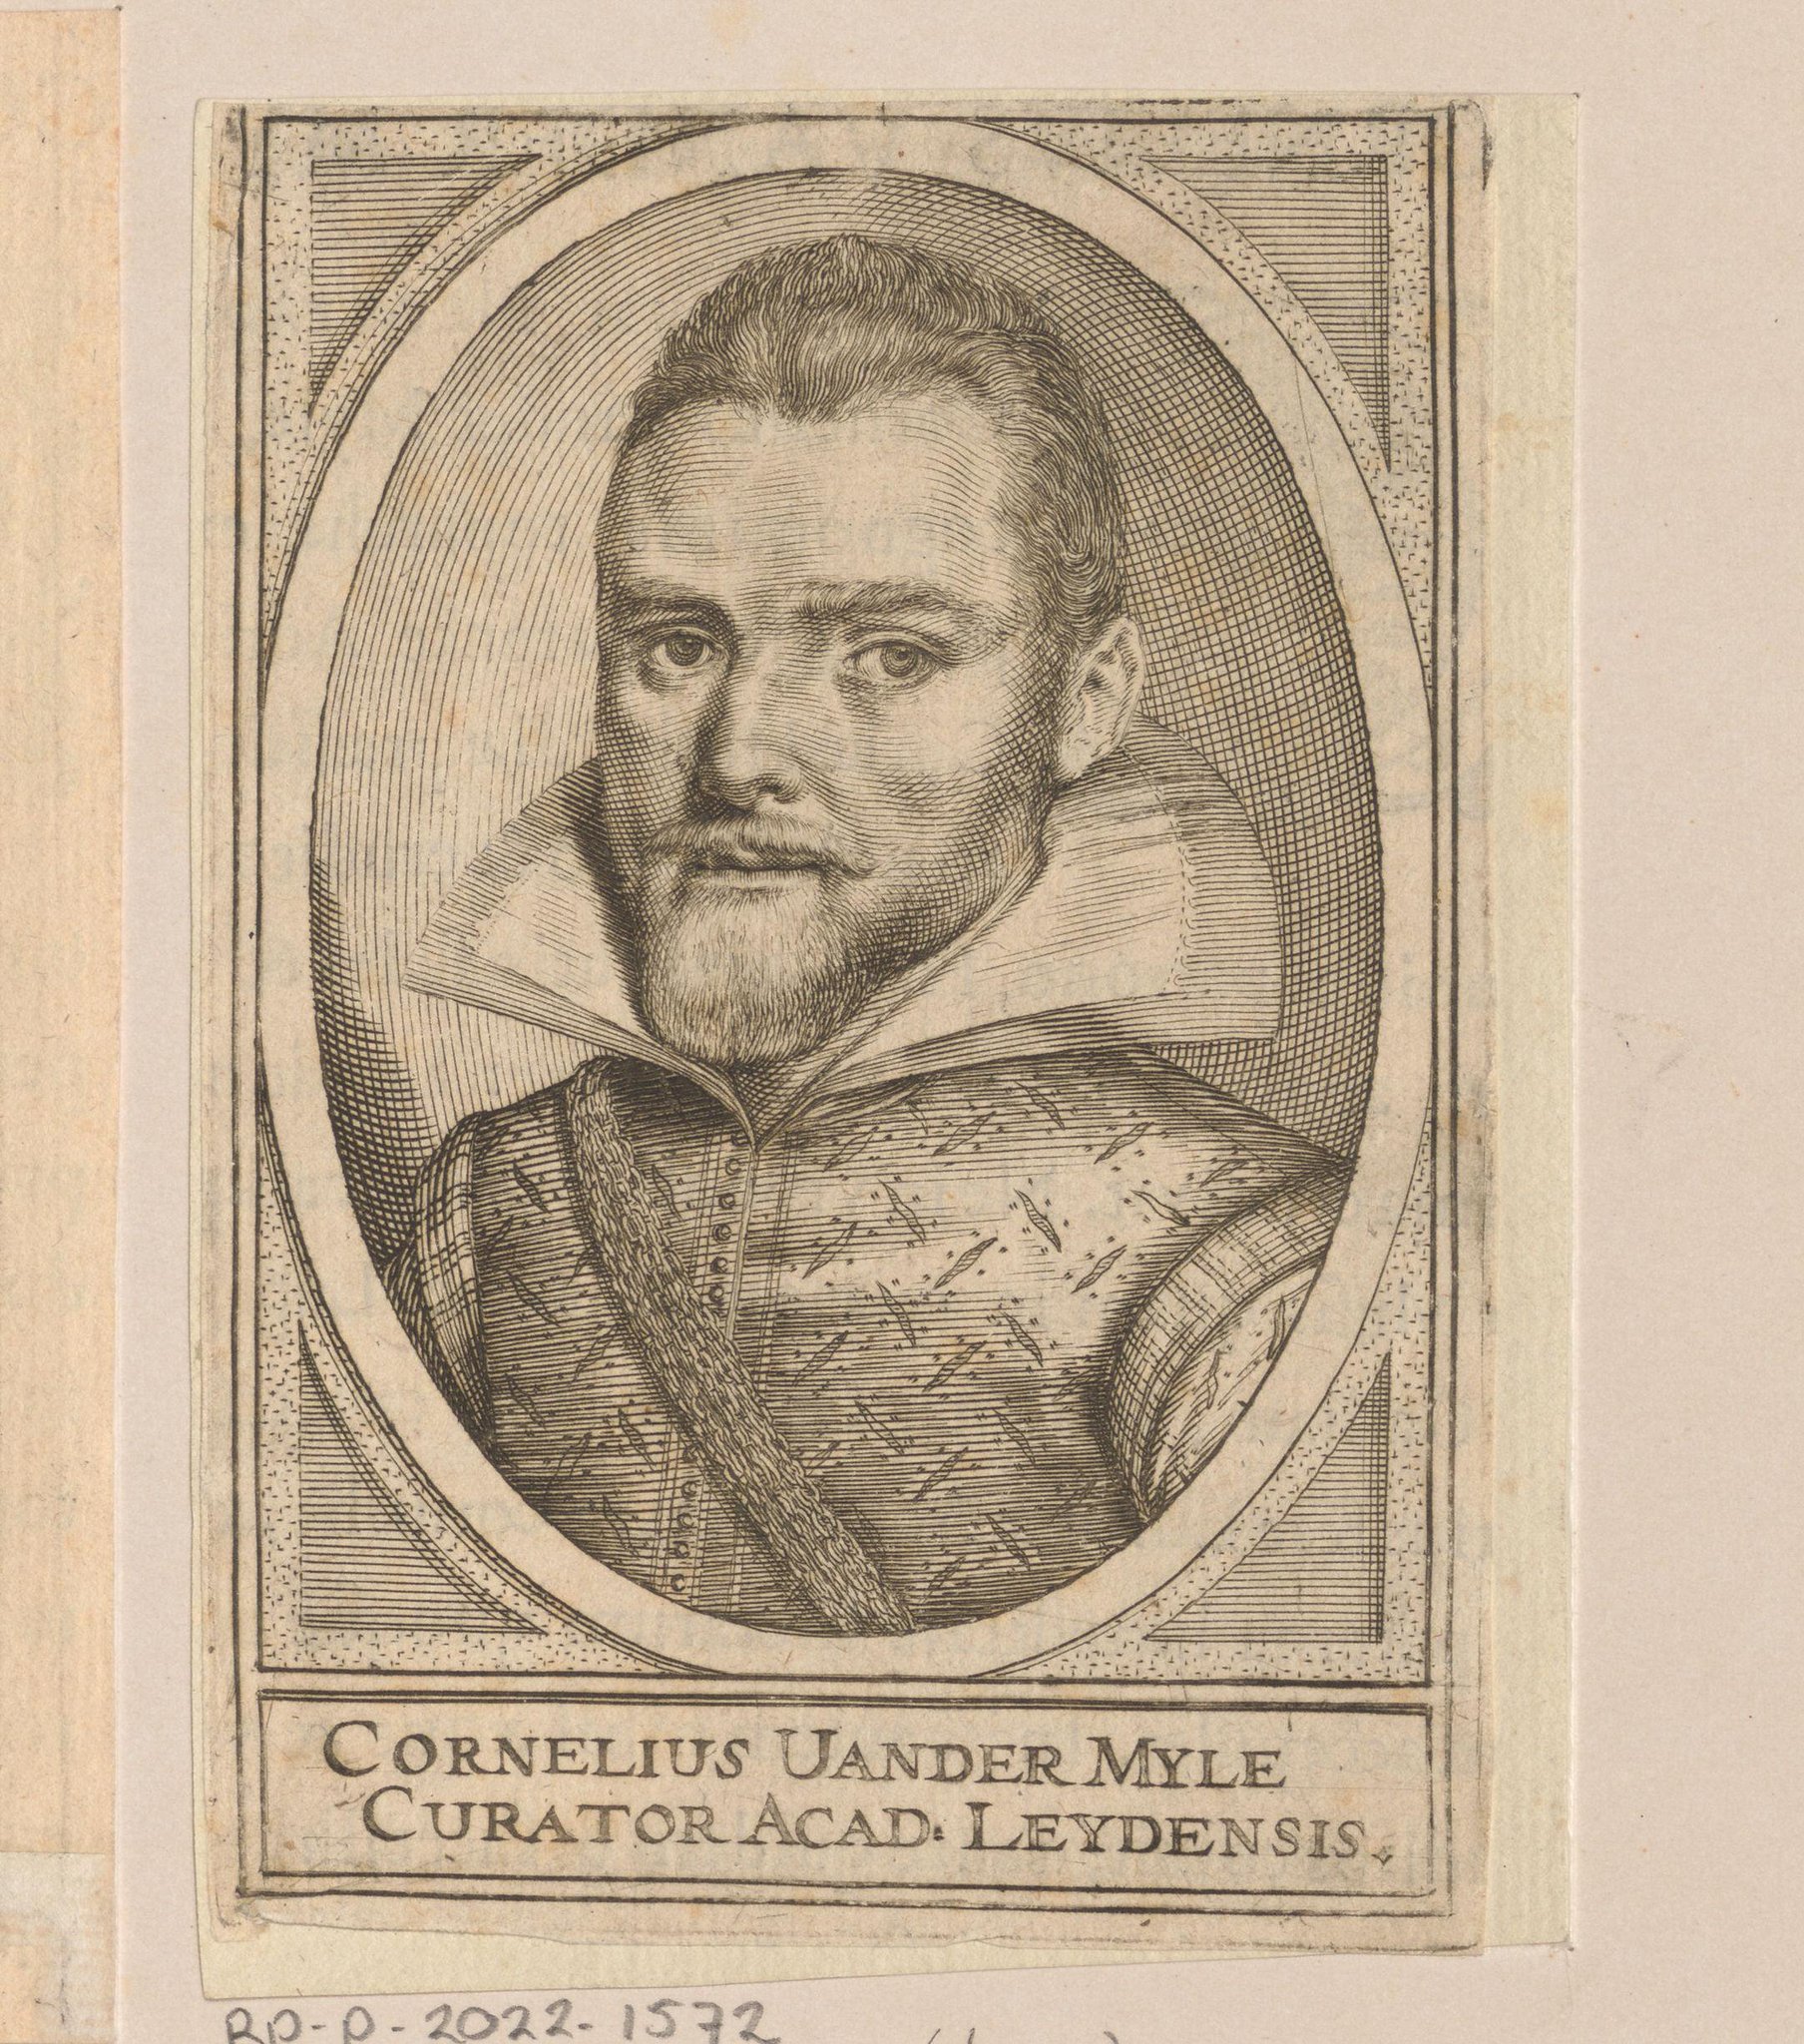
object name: print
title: Portret van Cornelis van der Myle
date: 1614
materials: paper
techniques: engraving, letterpress printing, snipping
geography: leiden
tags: the hague, politician, historical persons, politician, e.g. party leader, diplomacy, diplomat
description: Prent uit: Meurs, Johannes van. Illustrium Hollandiae et Westfrisiae ordinum alma Academia Leidensis contenta proxima pagina docebit (...). Leiden: Jacob Marcus en Joost van Colster, 1614.